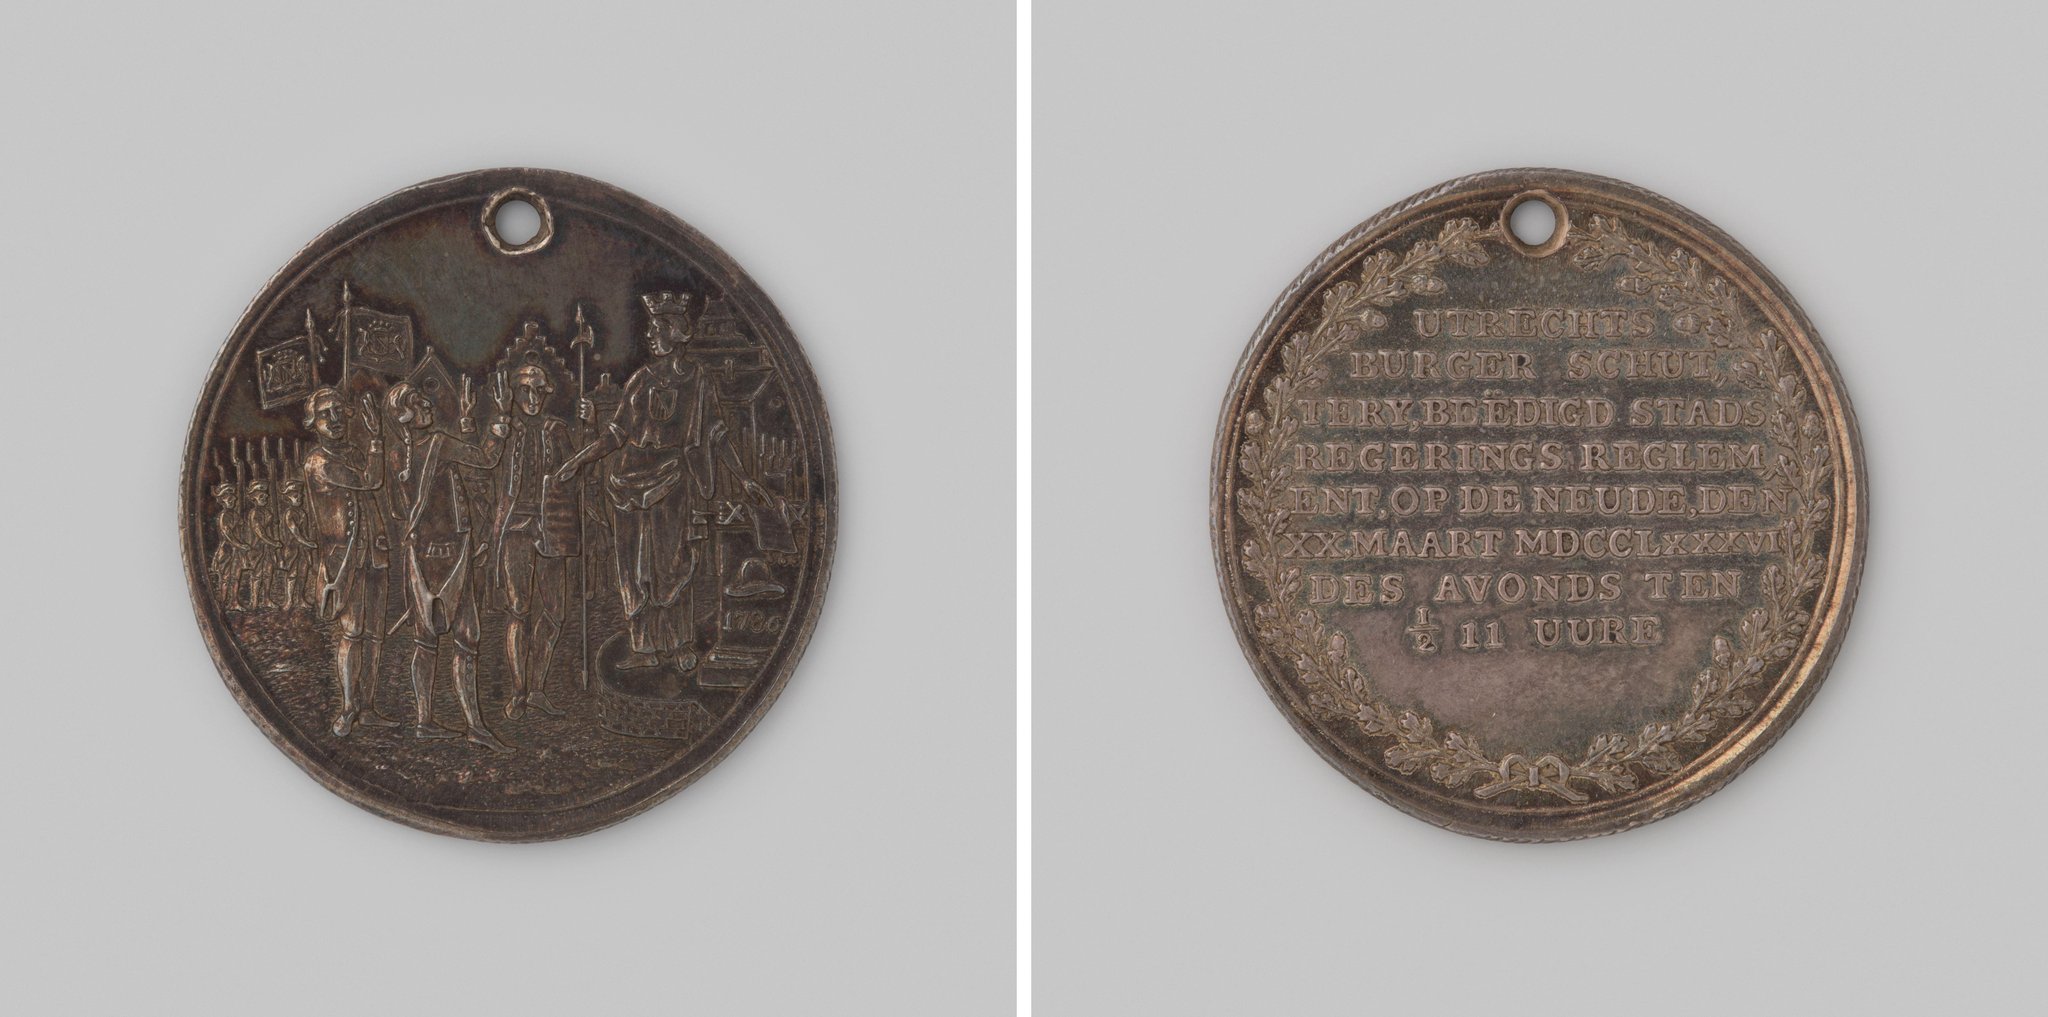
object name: history medal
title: Beëdiging van het regeringsreglement op de Neude te Utrecht 1786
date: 1786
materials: silver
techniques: striking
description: Zilveren penning met kabelrand en doorboring, op de voorzijde de Utrechtse Stedemaagd, staand naast een altaar gemerkt 1786 waarop een oorkonde ligt, terwijl ze op de Neude de eed op het regeringsreglement afneemt aan drie schutters, op de keerzijde acht regels tekst tussen samengestrikte eikentakken.